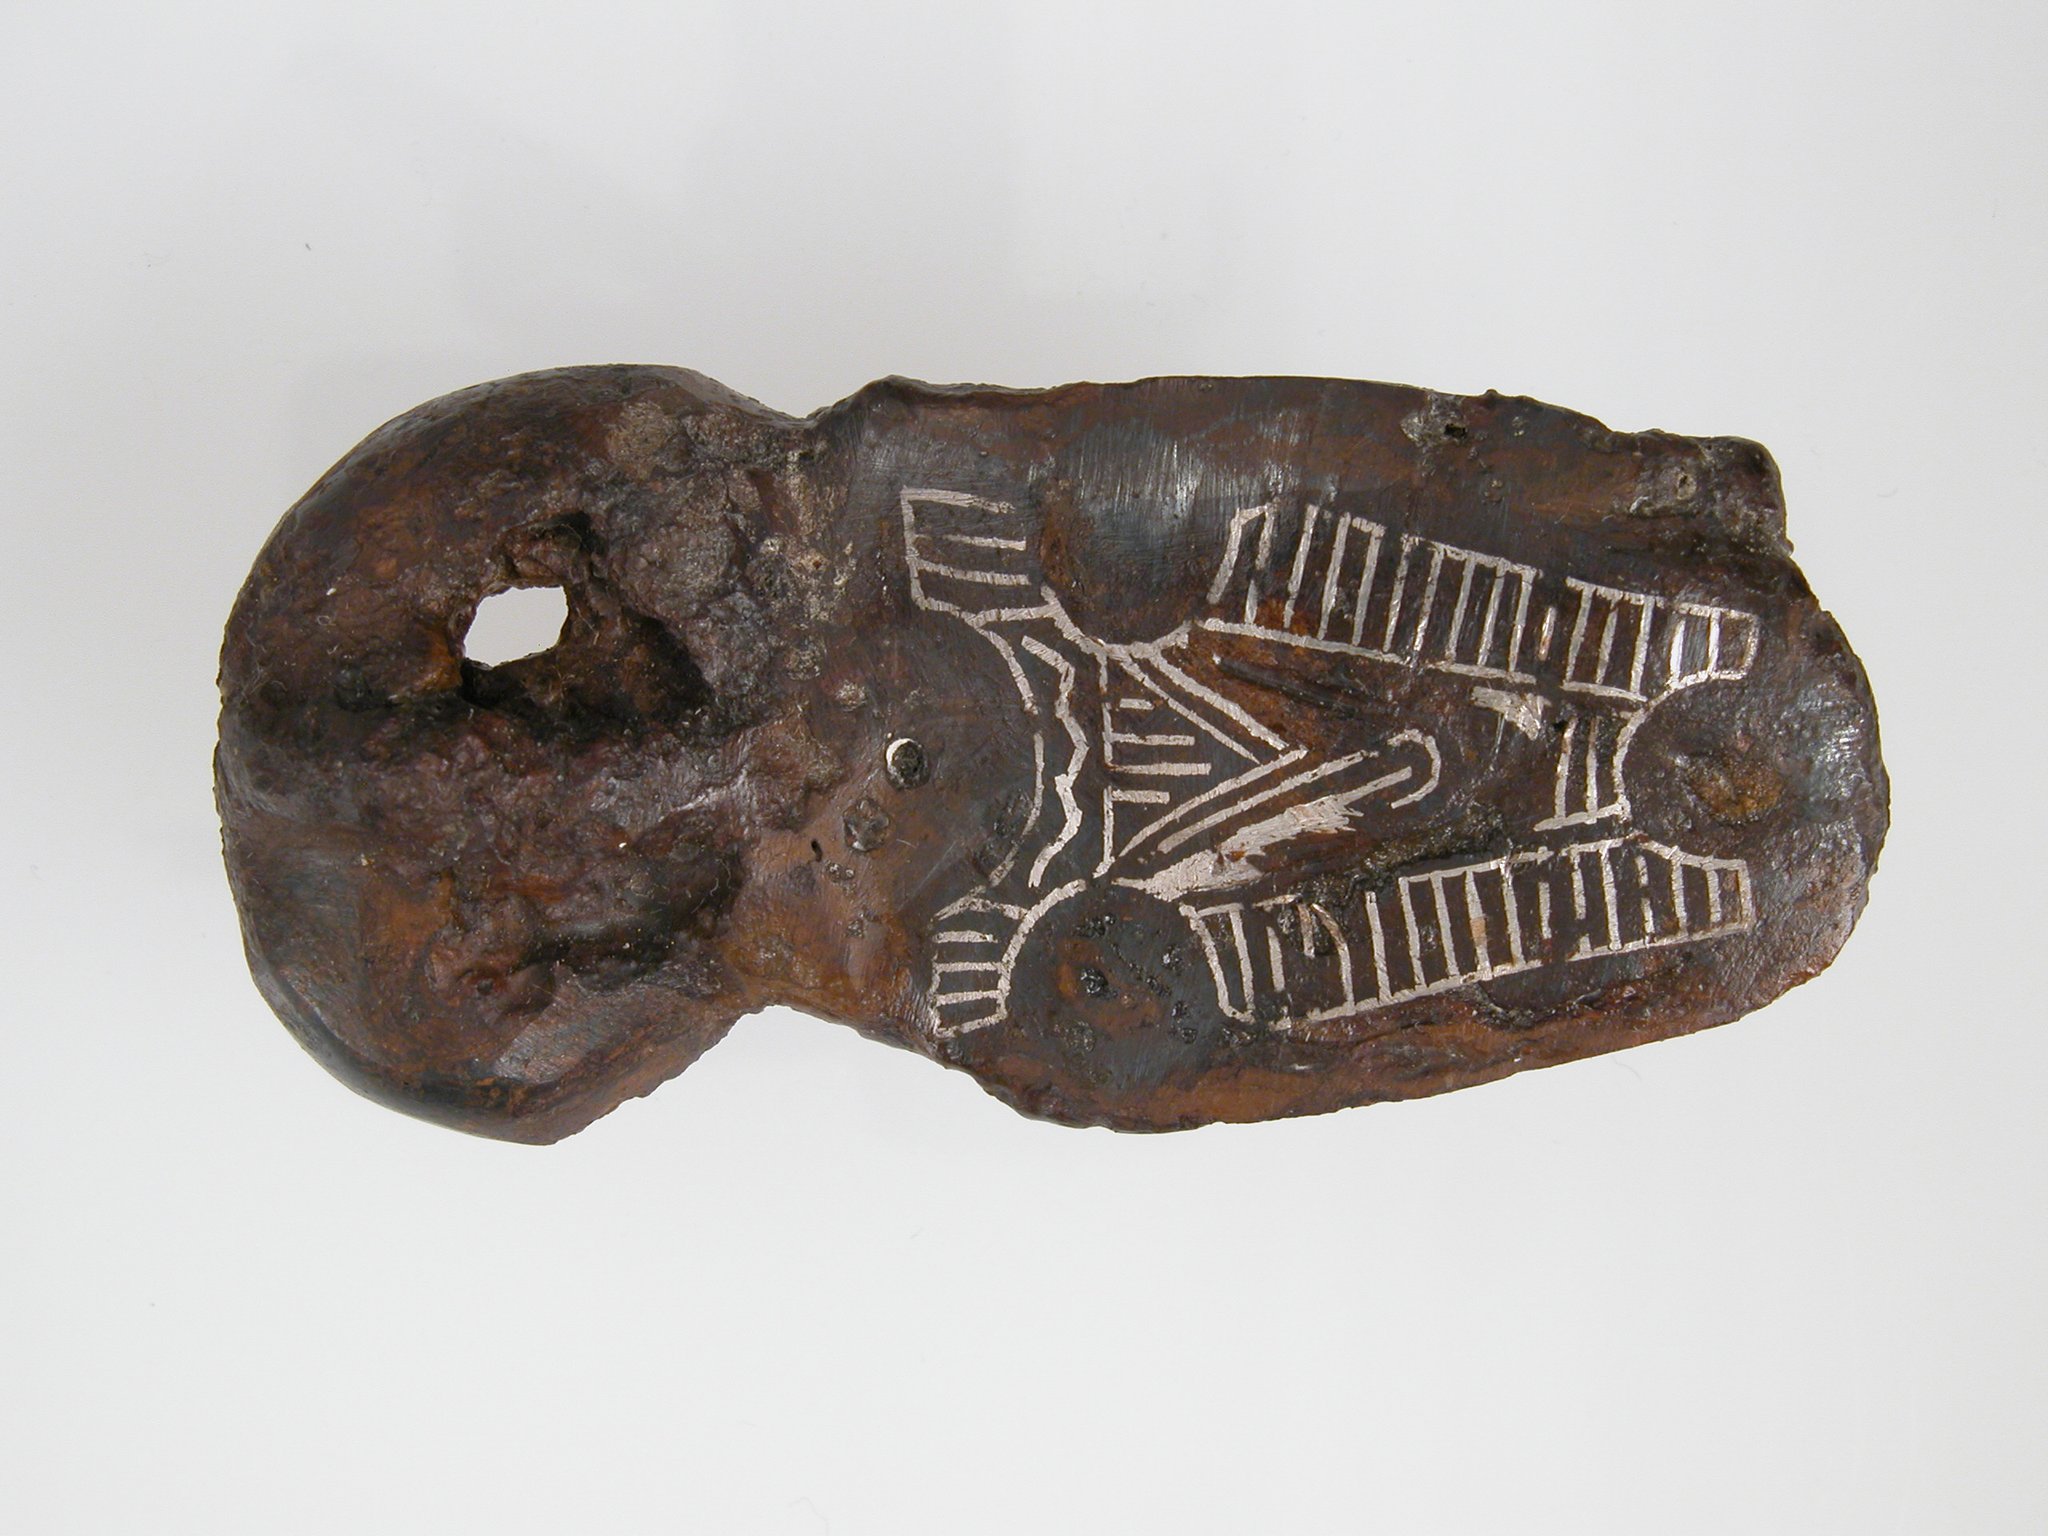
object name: belt buckle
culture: frankish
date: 601-700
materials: iron, silver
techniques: inlay